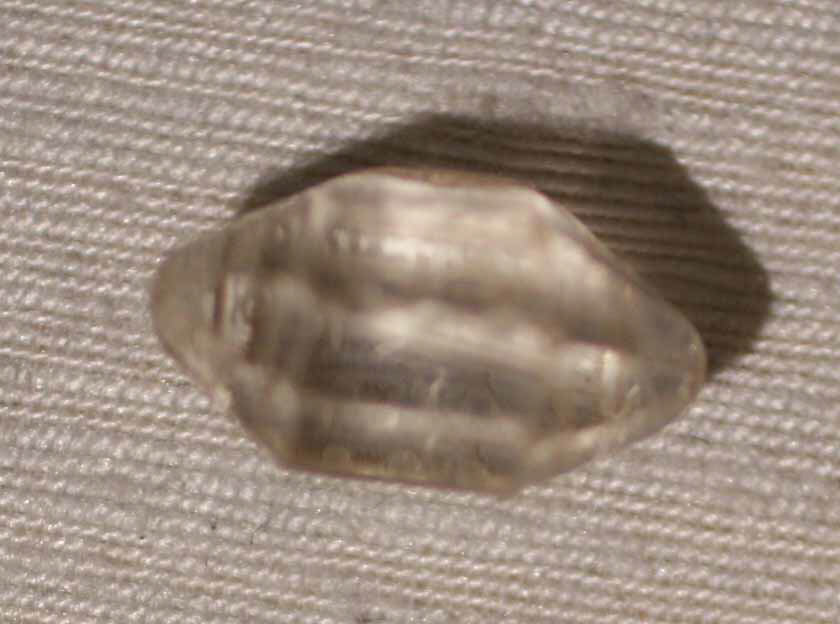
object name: pendant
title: Rock Crystal Pendant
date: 801-1000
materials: quartz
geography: iran